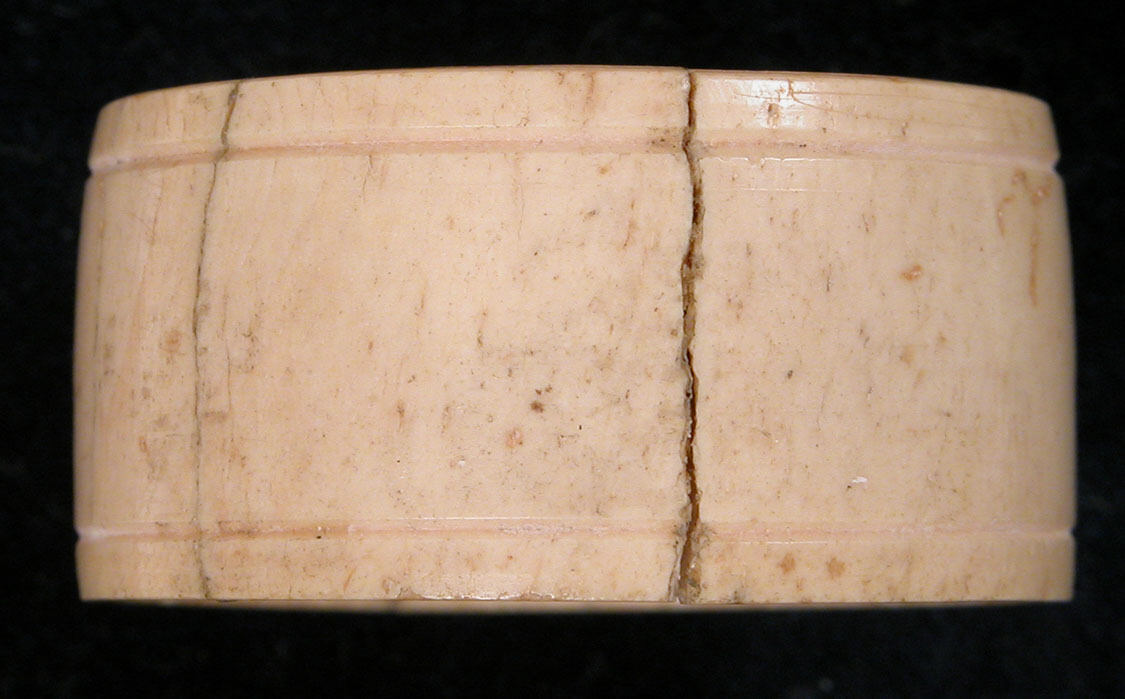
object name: jar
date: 401-800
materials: bone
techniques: incising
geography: palestine